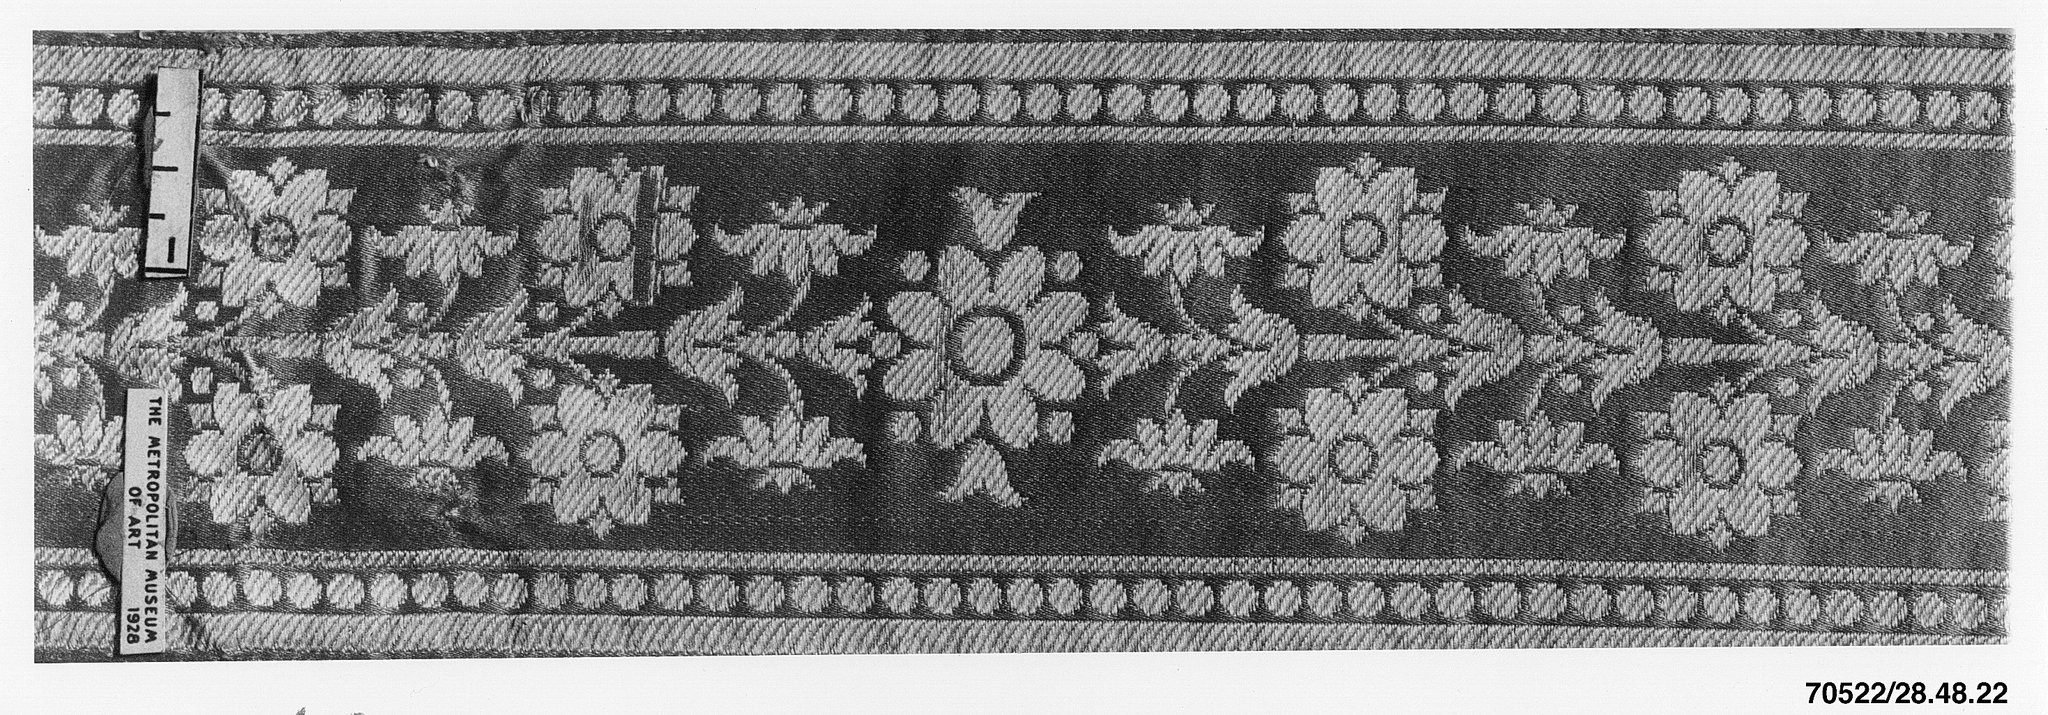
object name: piece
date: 1801-1900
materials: silk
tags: flowers